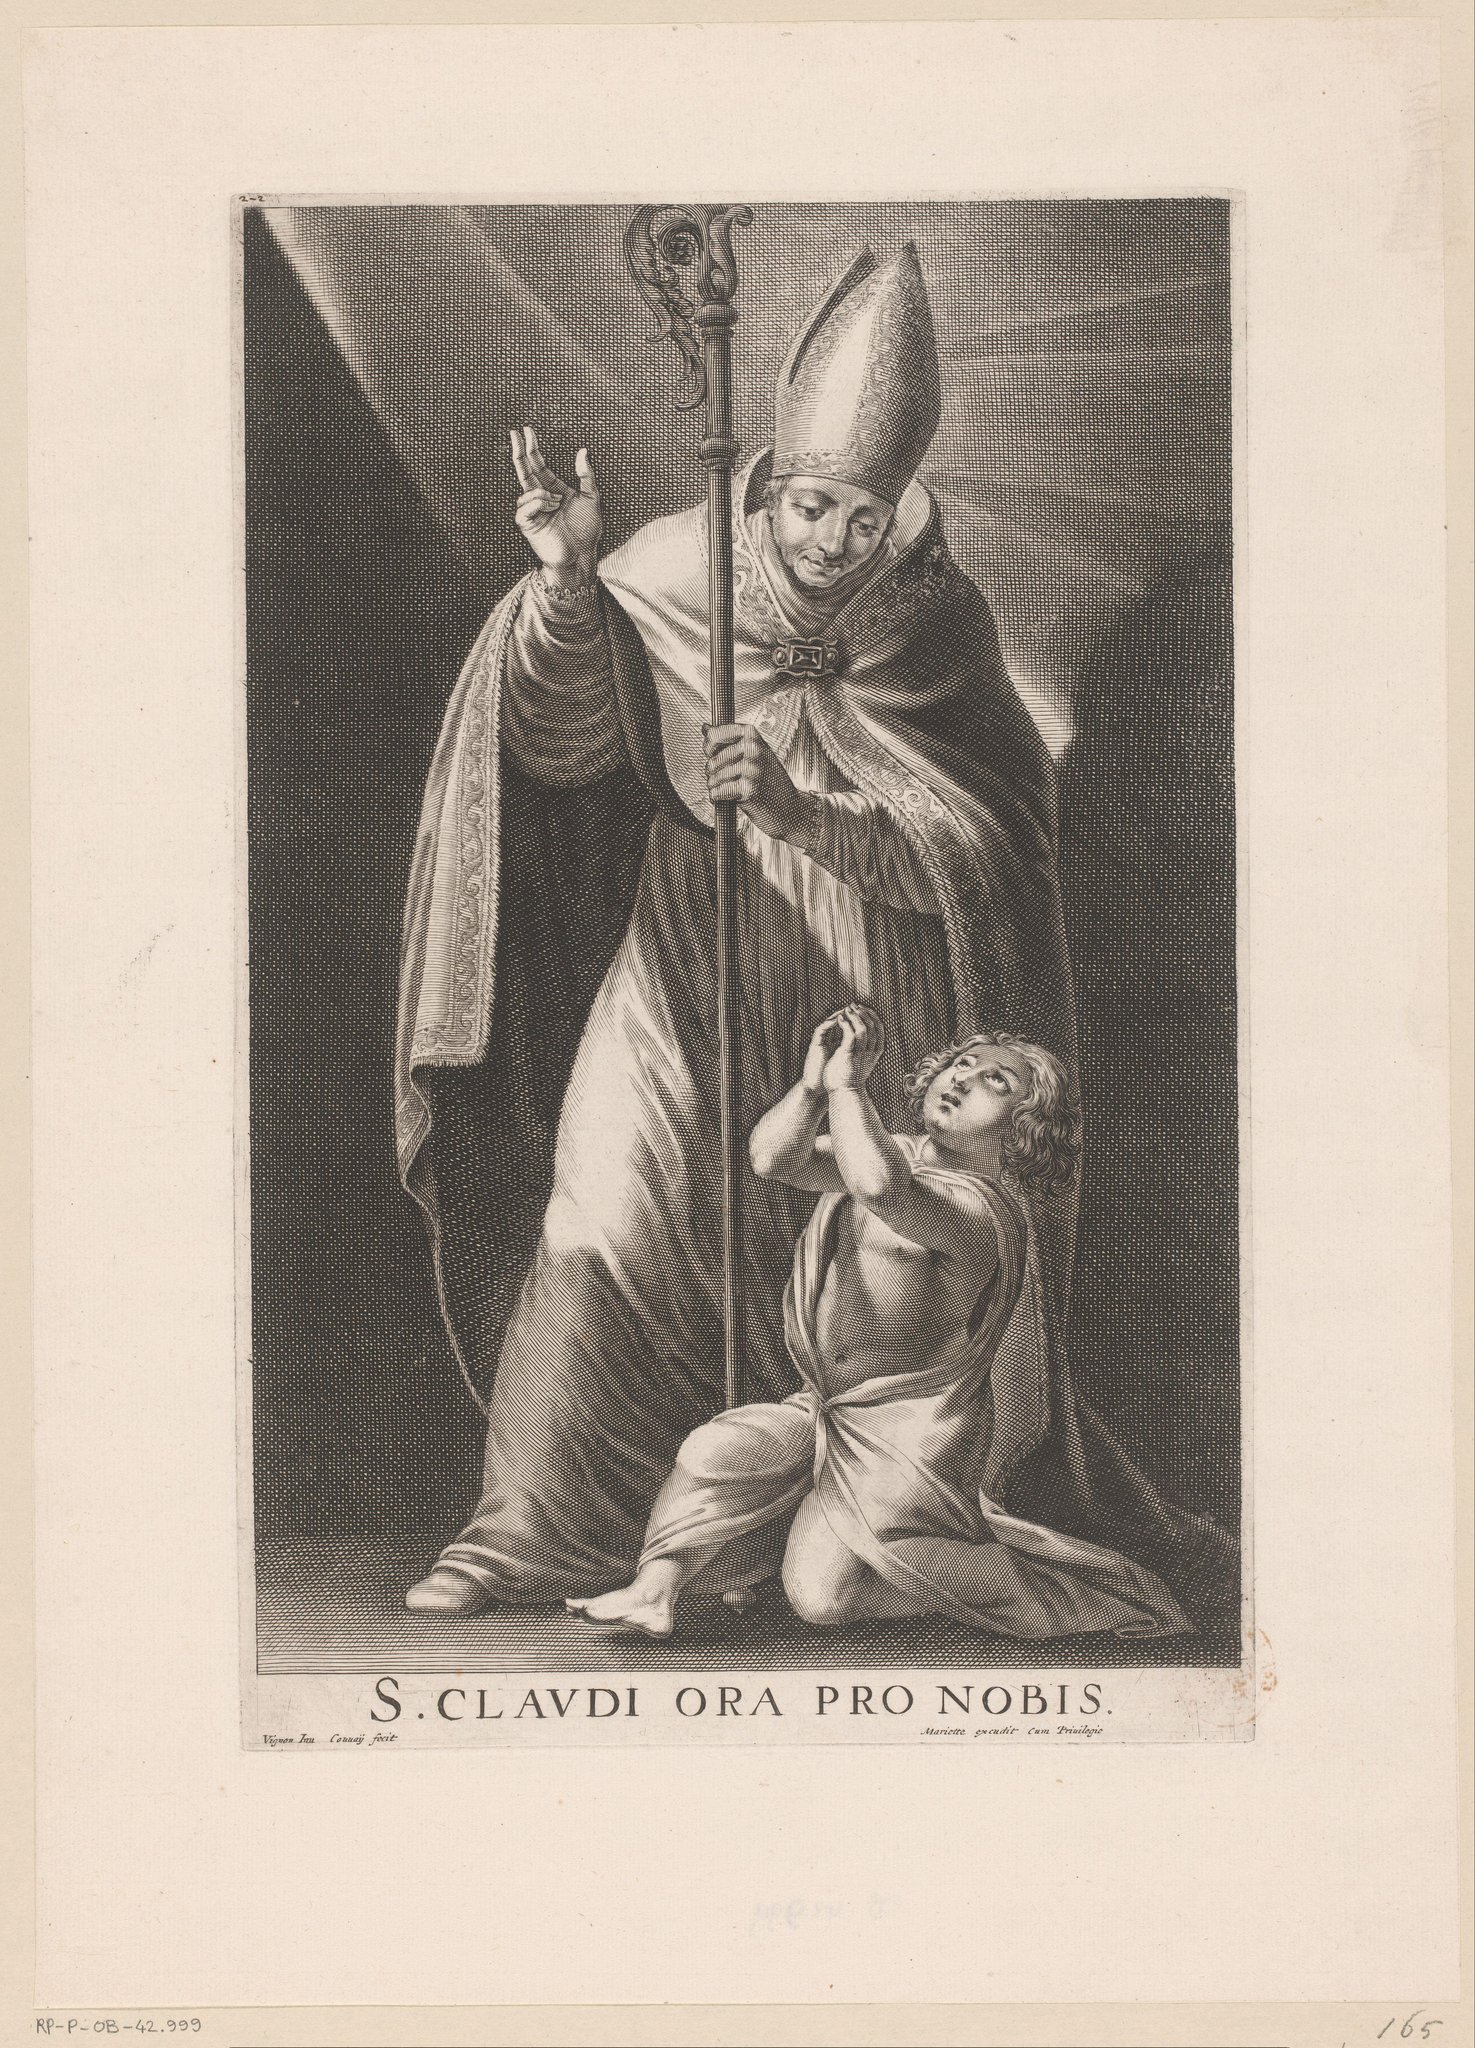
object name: print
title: Heilige Claudius van Besançon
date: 1632-1657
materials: paper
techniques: engraving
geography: paris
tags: male saints (with name)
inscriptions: collector's mark: Lugt 240